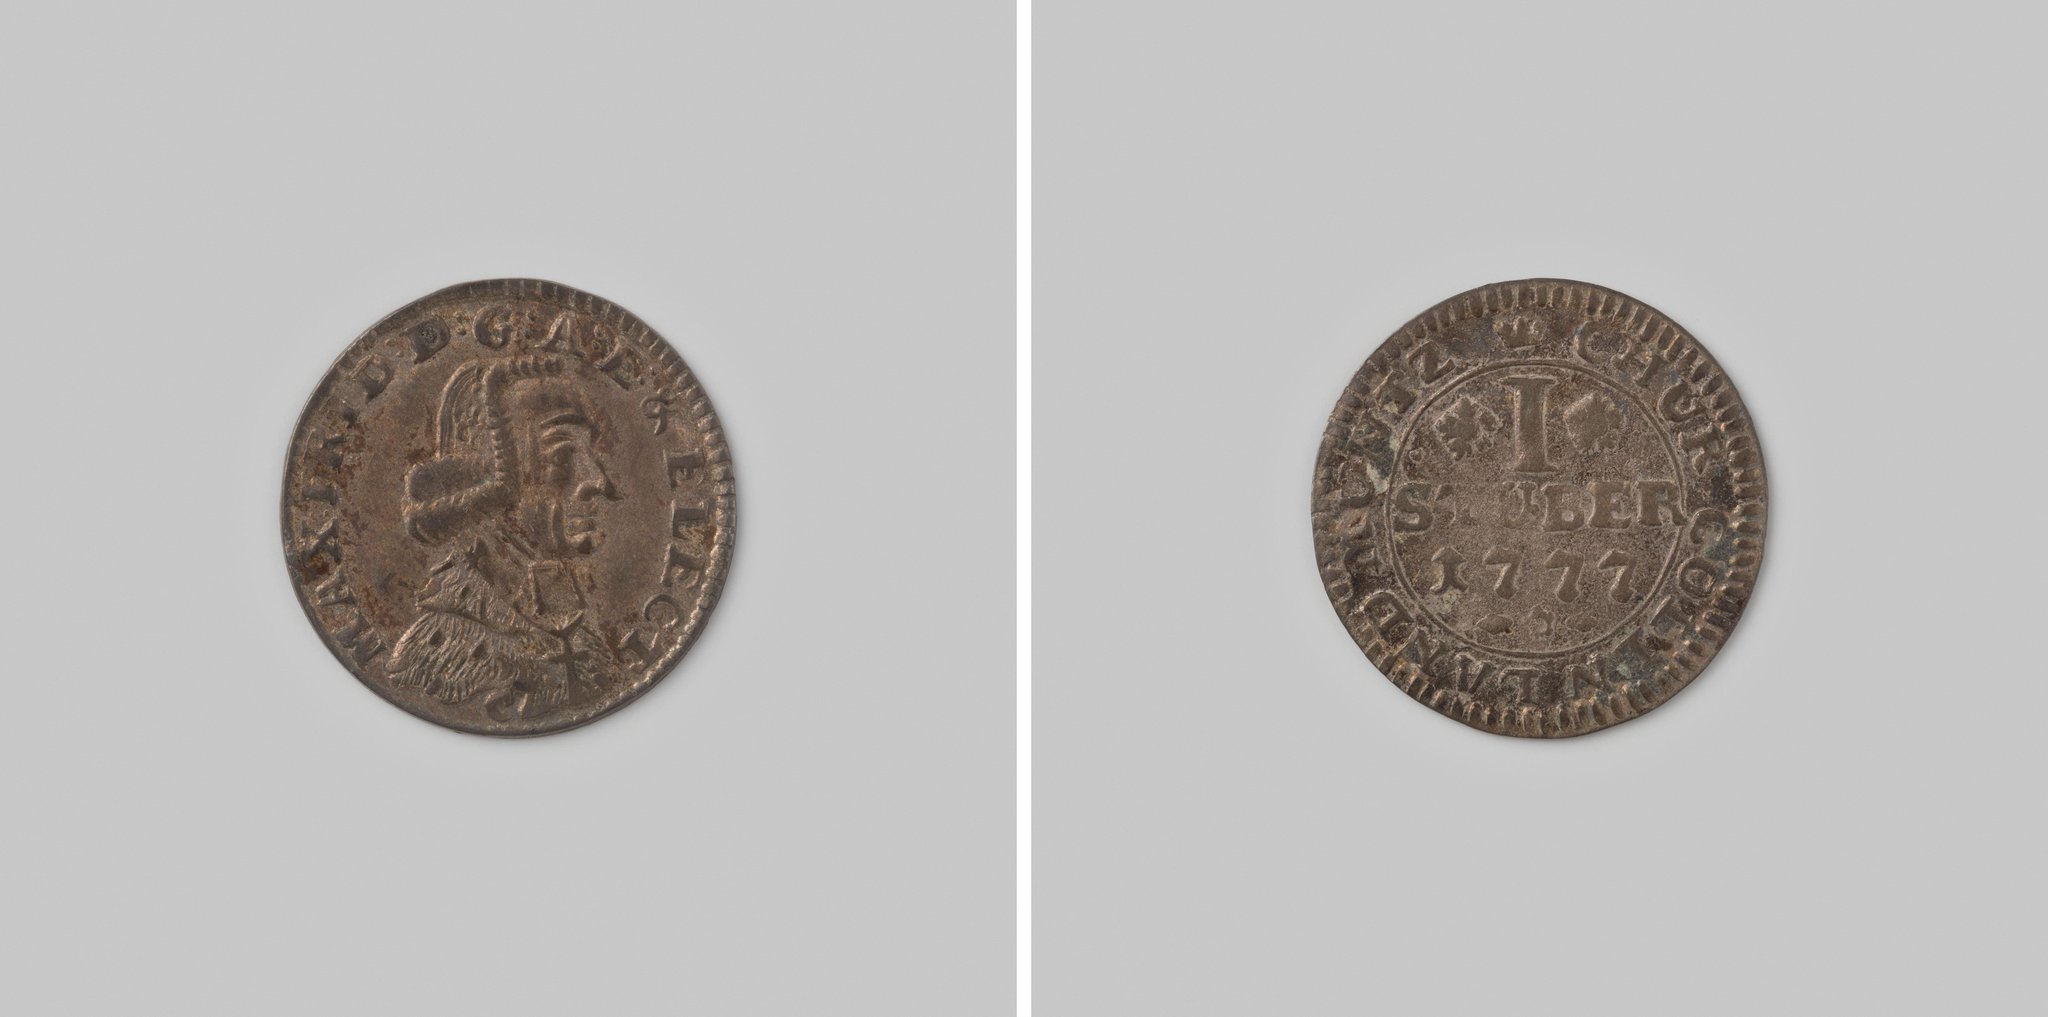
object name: coin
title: Bisdom Keulen, Maximilian Friedrich, stüber, 1777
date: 1777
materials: silver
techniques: striking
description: Zilveren munt. Voorzijde: portret van de bisschop en keurvorst naar rechts. Keerzijde: waarde-aanduiding in twee regels, waaronder jaartal. Gladde rand.